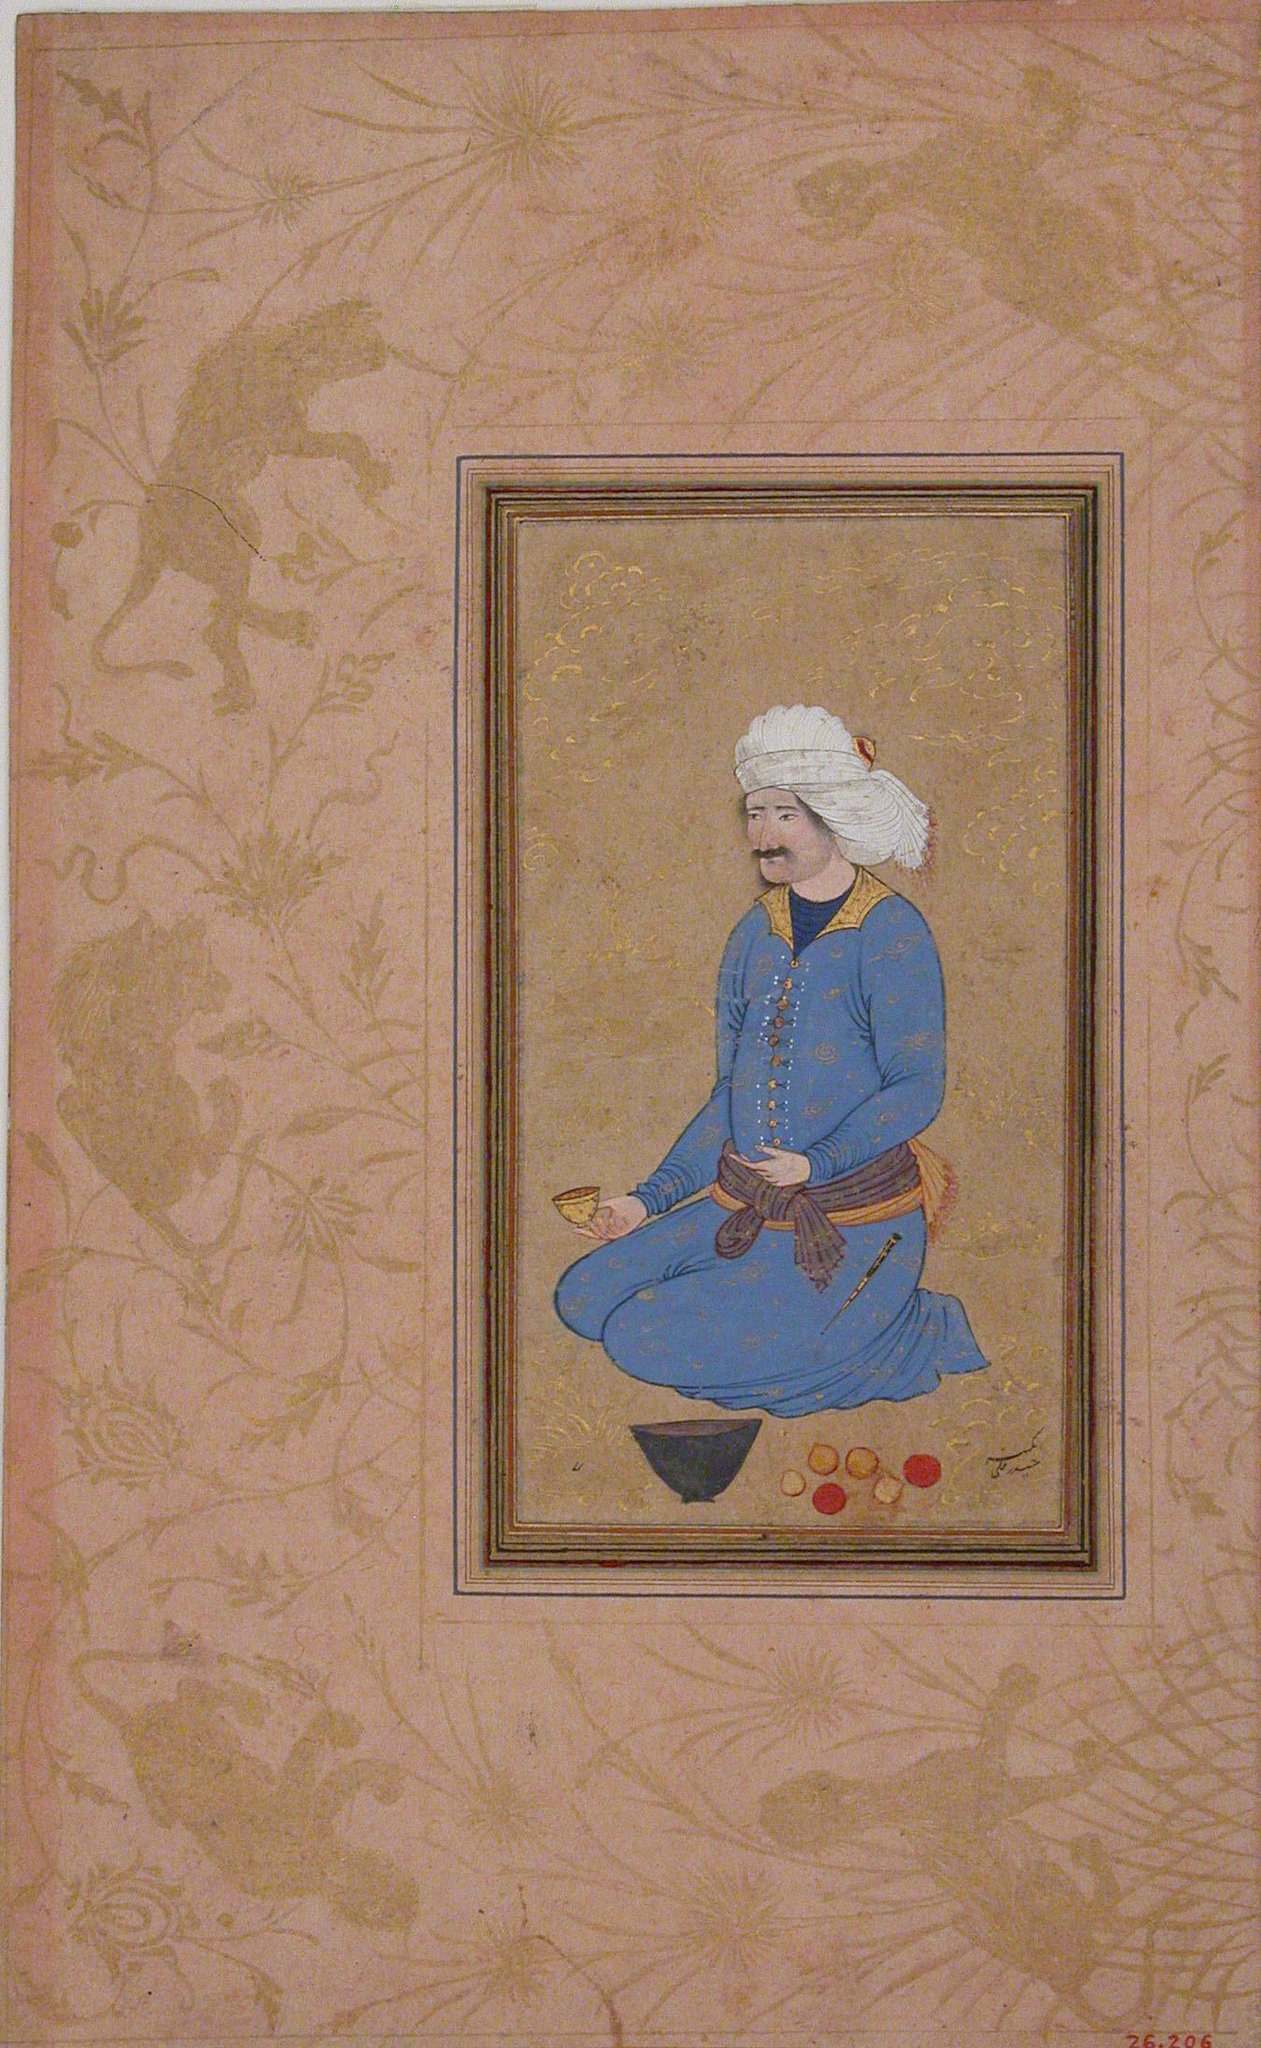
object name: illustrated album leaf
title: Portrait of Haidar Quli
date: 1501-1700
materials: paper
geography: iran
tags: men,portraits